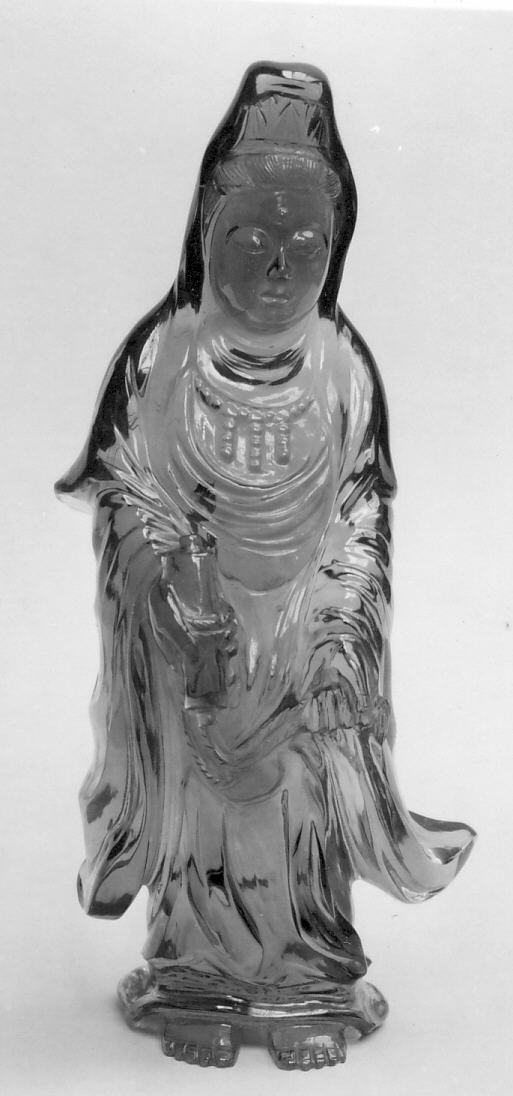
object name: figure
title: Guanyin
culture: chinese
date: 1801-1900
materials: quartz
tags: buddhism,bodhisattvas